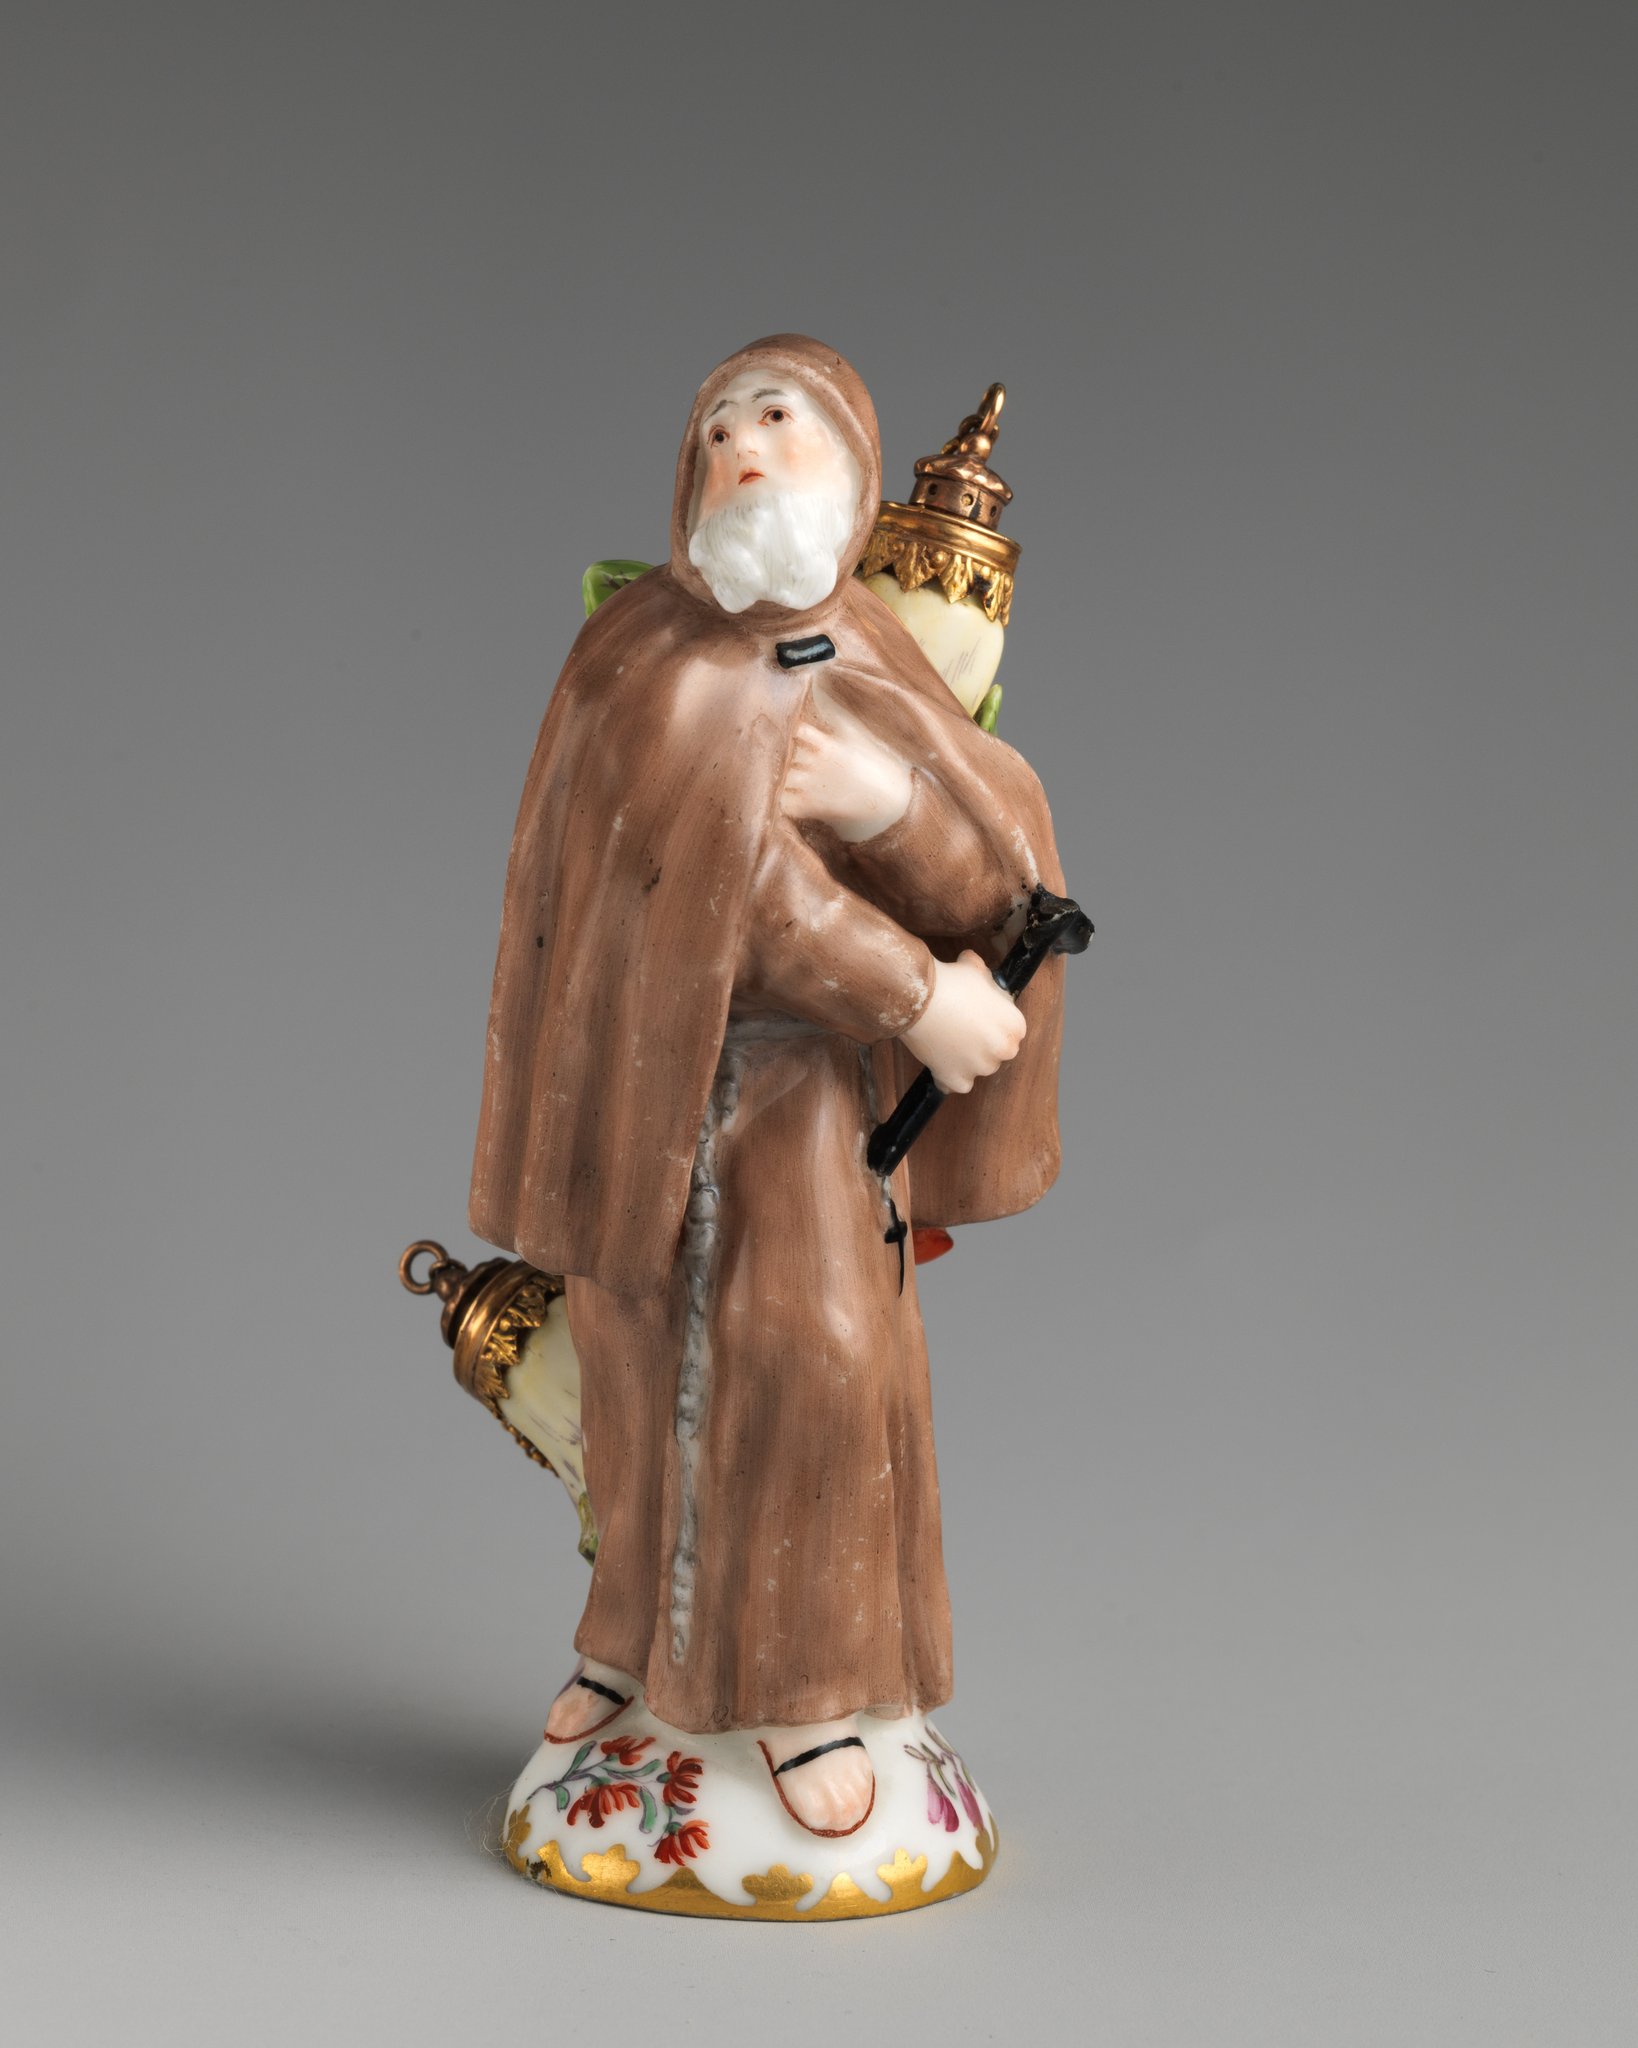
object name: toy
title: Friar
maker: chelsea porcelain manufactory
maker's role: factory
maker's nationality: british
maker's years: 1744-1784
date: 1755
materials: soft paste porcelain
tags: men